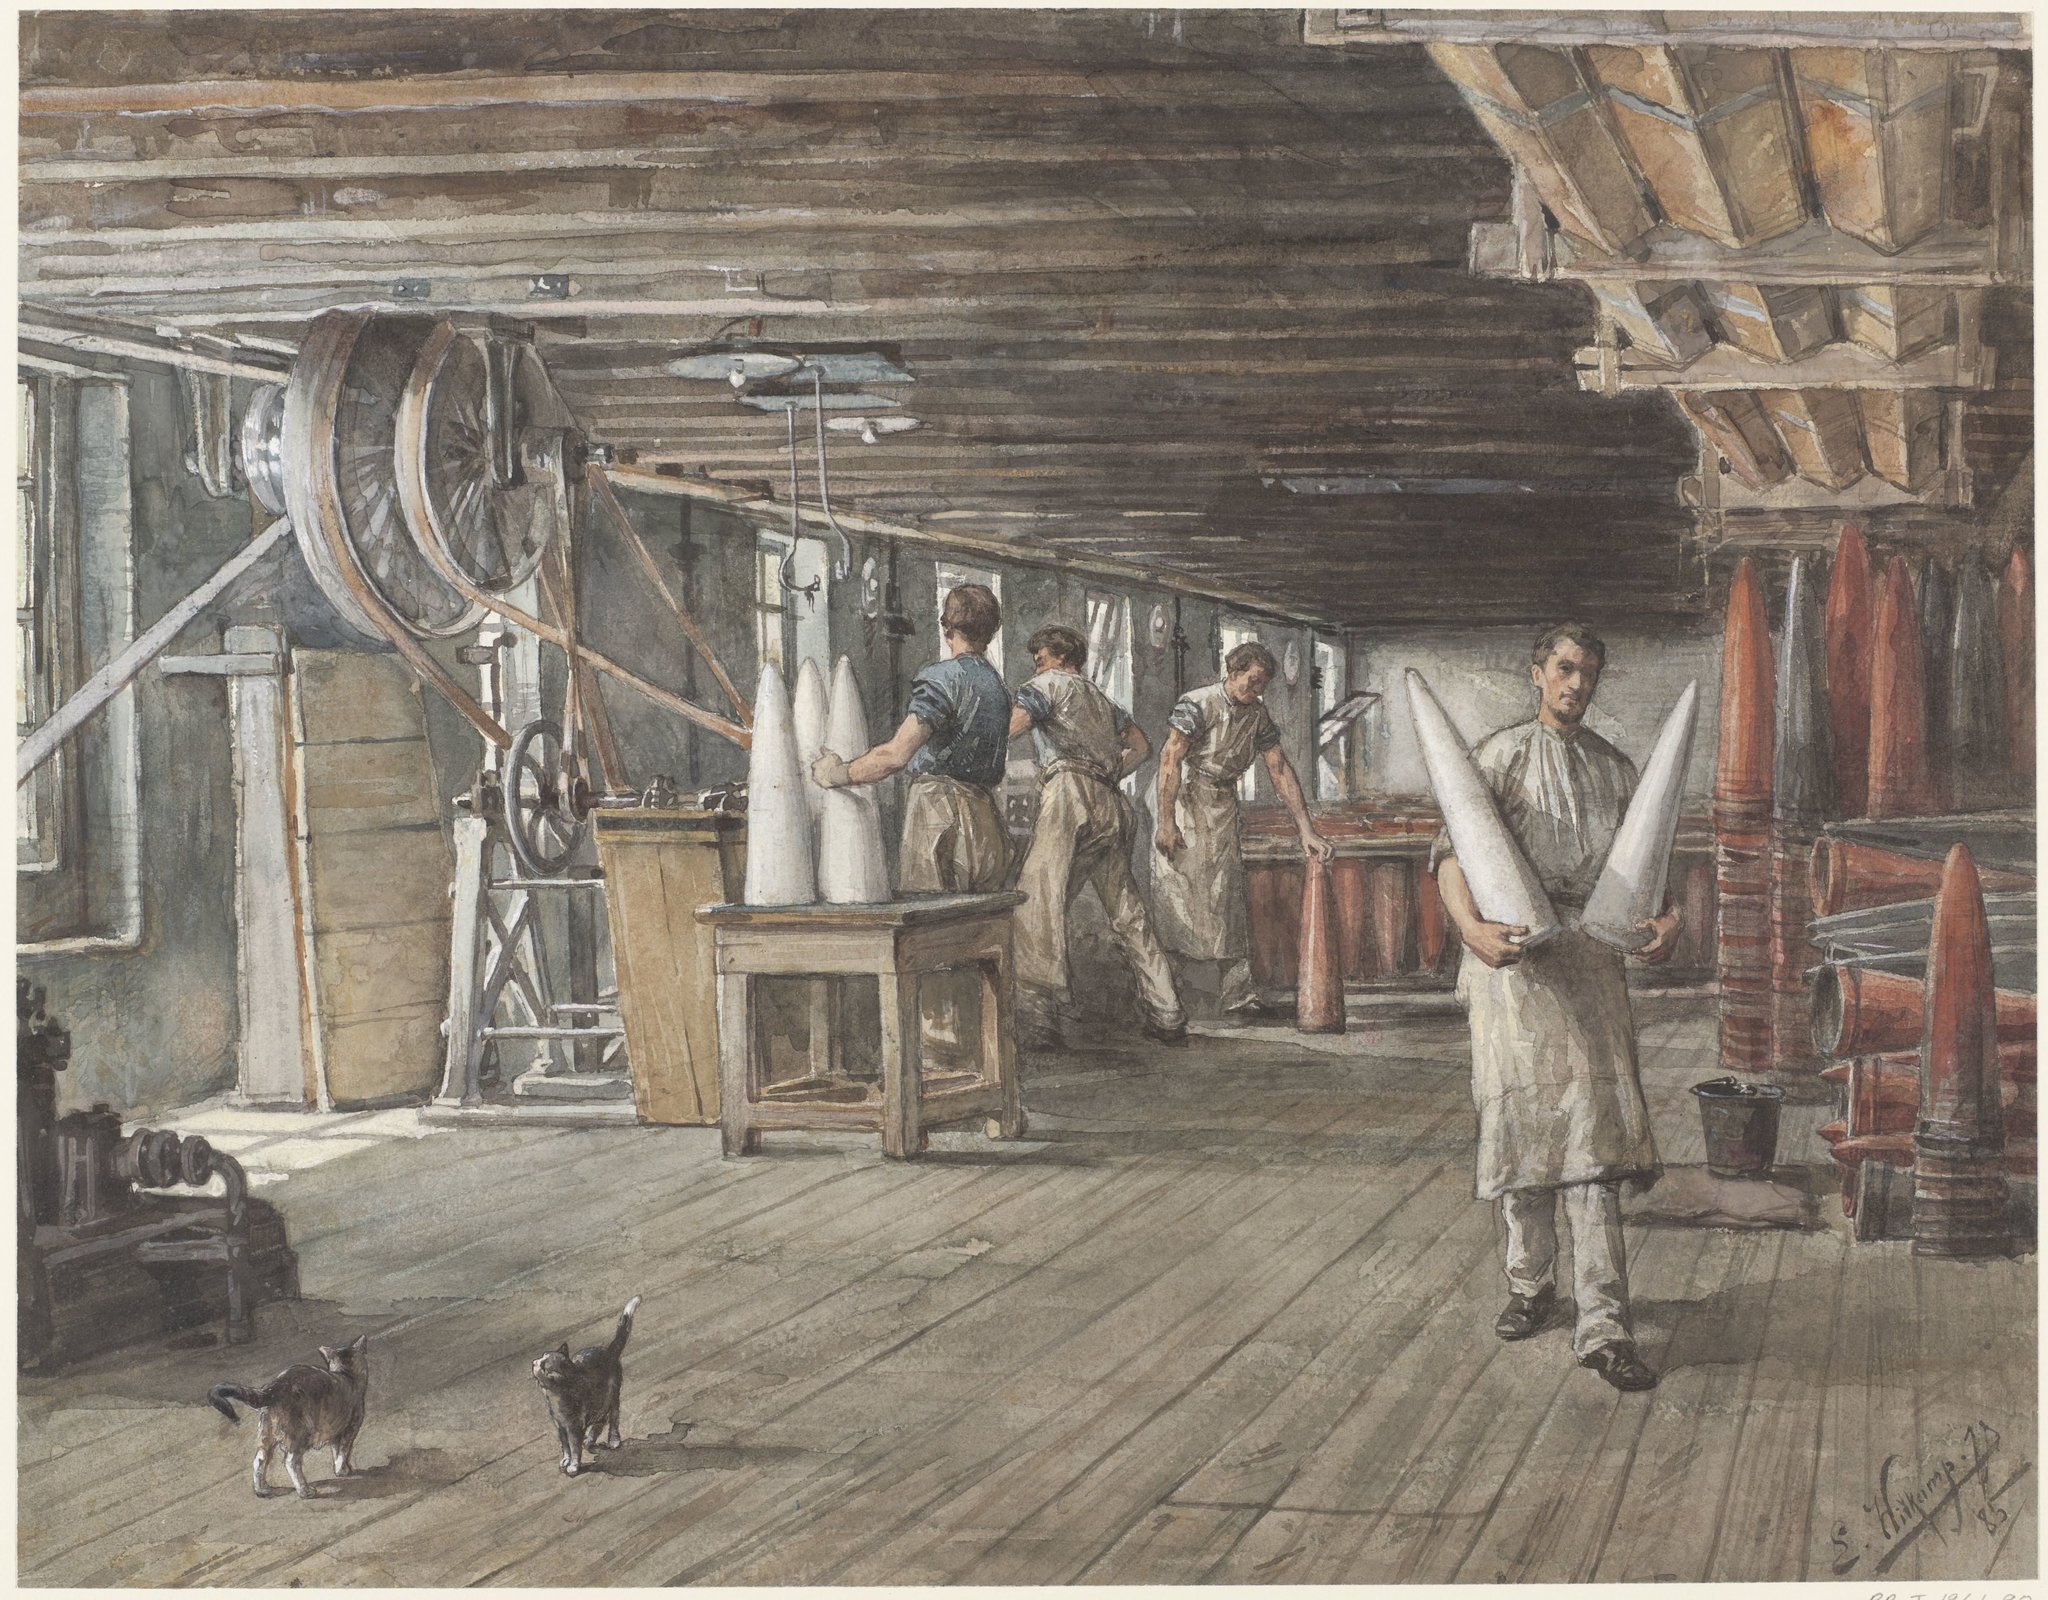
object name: watercolor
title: Interieur van de suikerfabriek van de firma Deichmann & Vom Rath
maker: ernst witkamp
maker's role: draughtsman, print maker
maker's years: 1854-1897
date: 1885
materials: paper, pencil, watercolor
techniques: brush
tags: industries ~ food, drink, stimulants, sugar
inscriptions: date: ‘85’